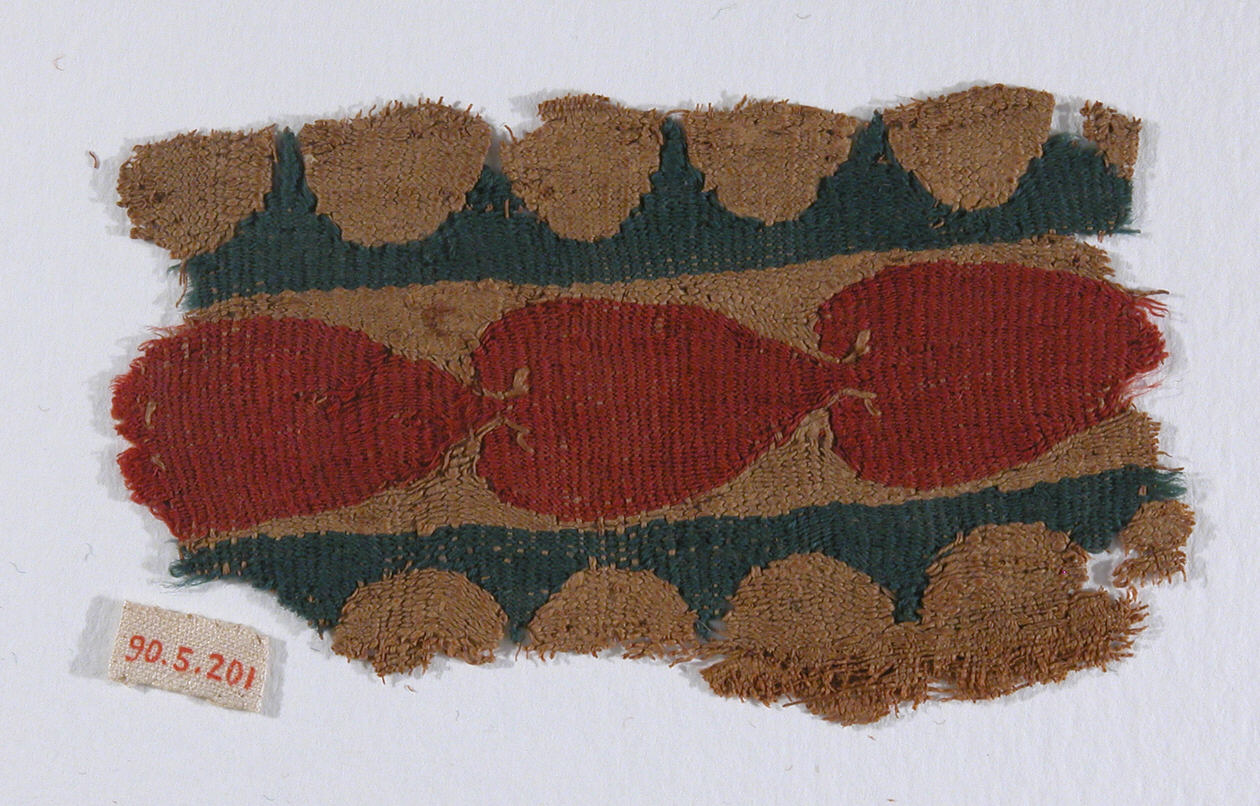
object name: textile fragment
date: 301-500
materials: linen, wool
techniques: weave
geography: egypt